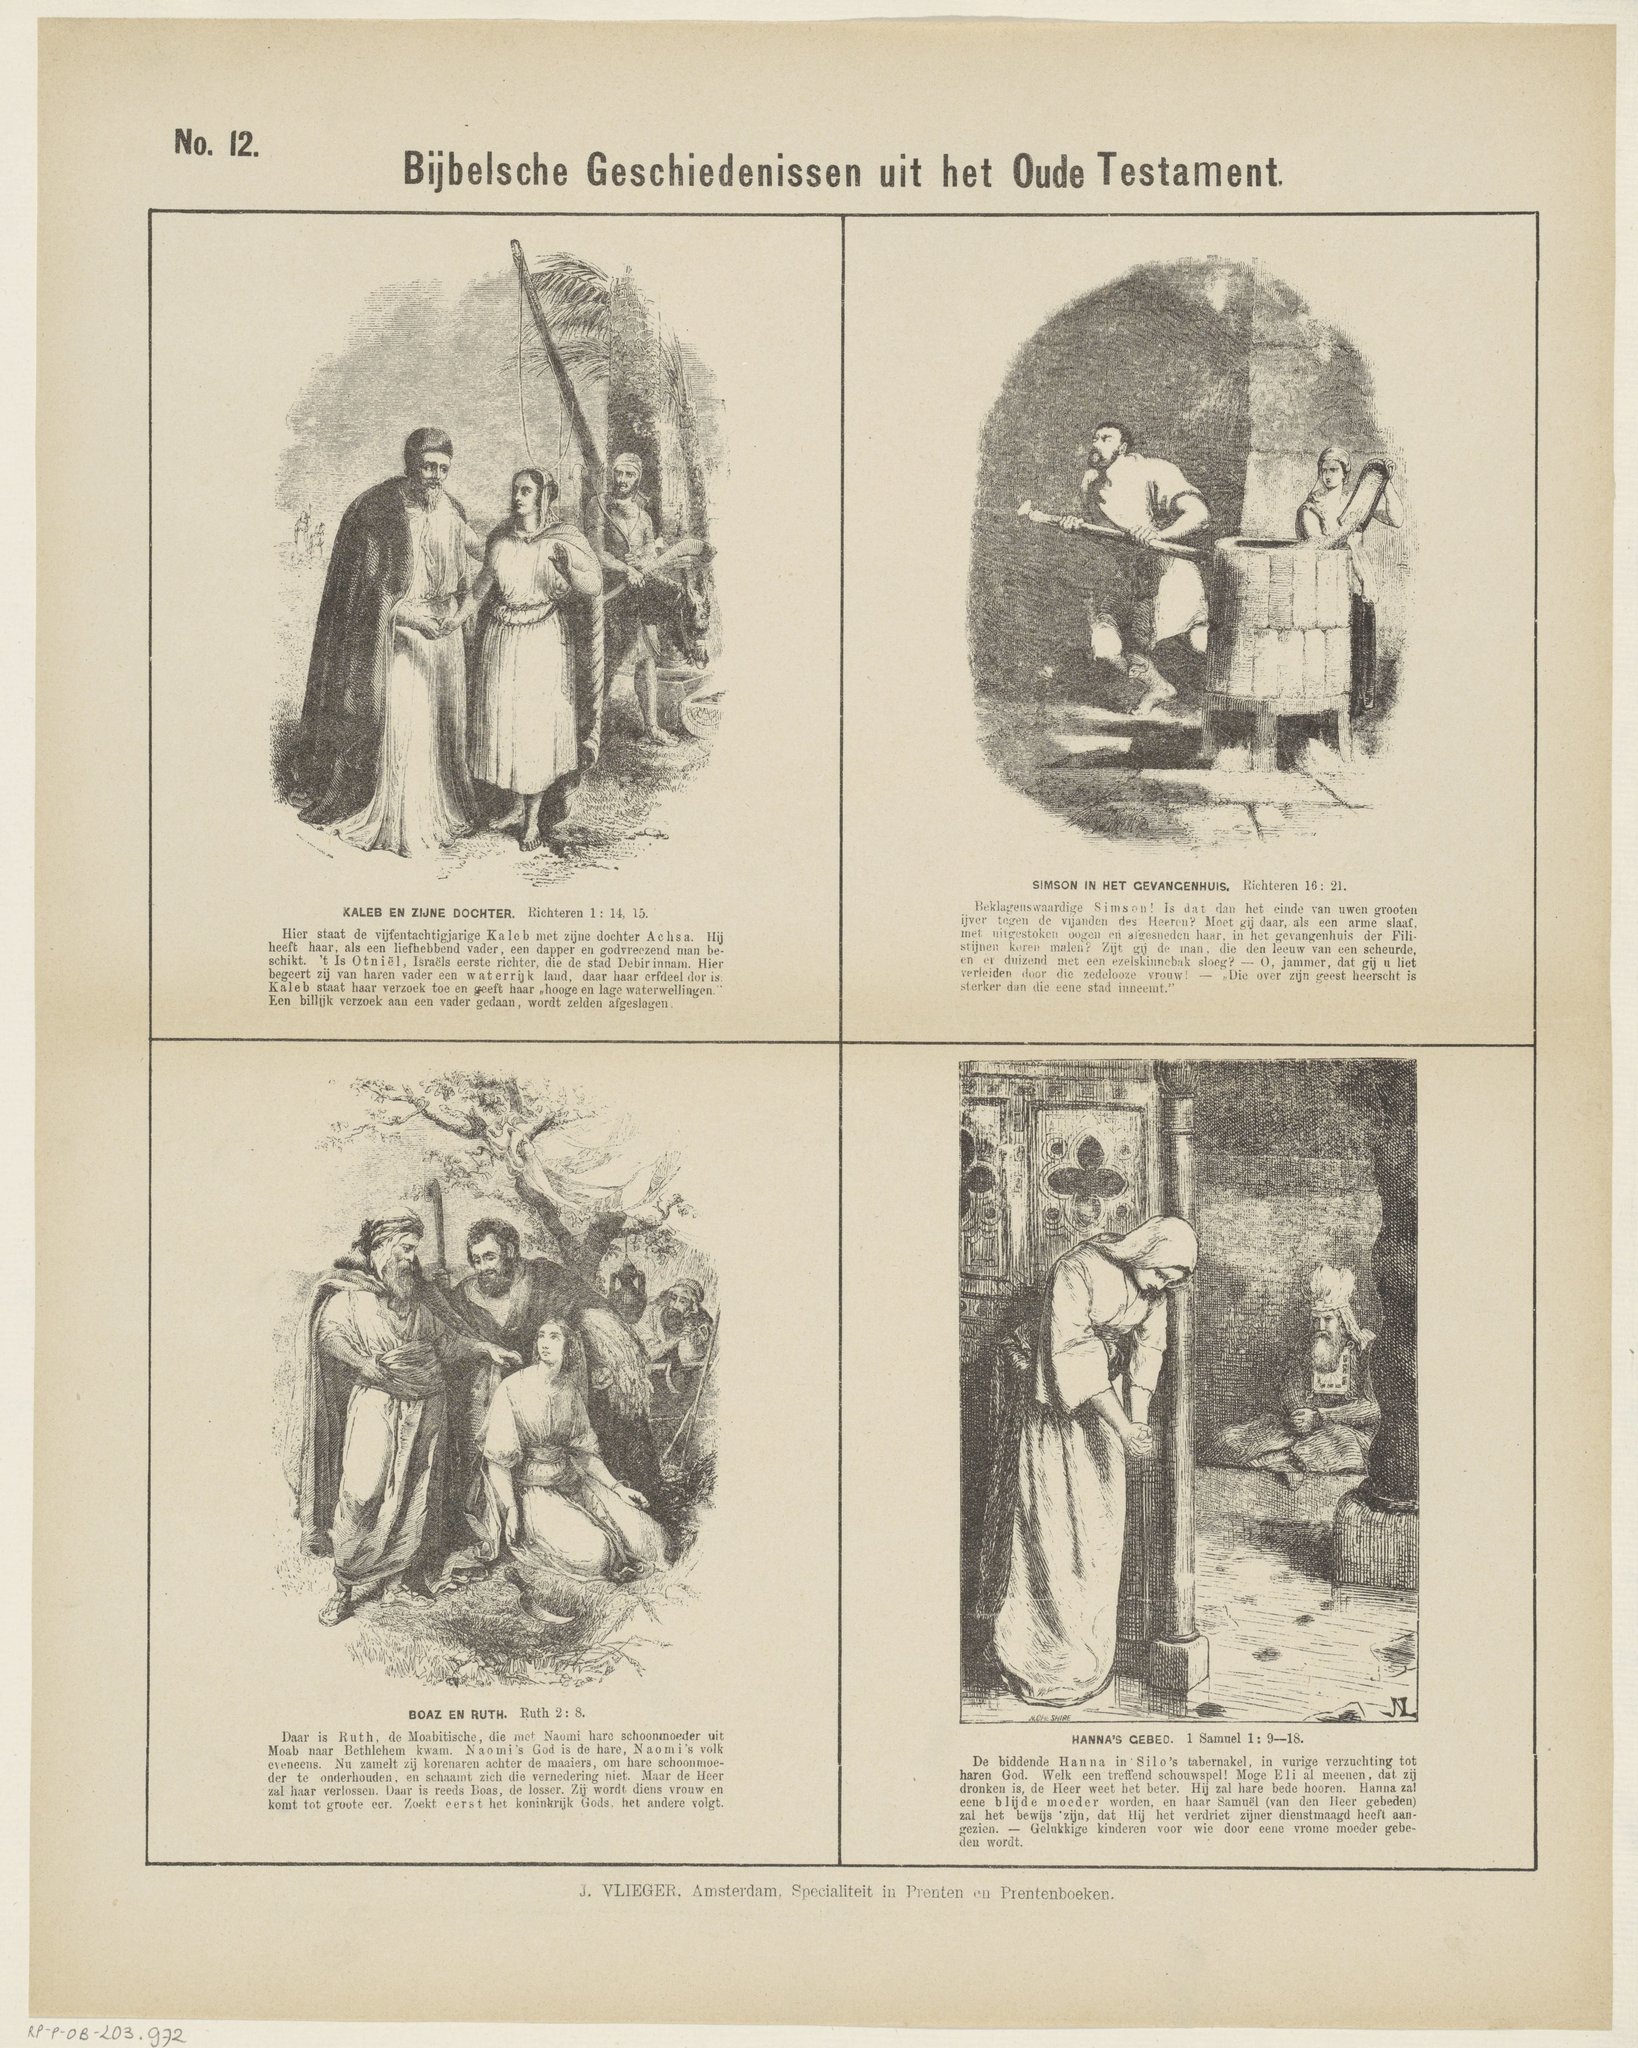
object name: popular print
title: Bijbelsche geschiedenissen uit het Oude Testament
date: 1871-1908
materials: paper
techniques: letterpress printing, engraving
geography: amsterdam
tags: samson grinding in prison (in a treadmill), ruth and naomi in bethlehem (ruth 2:1-2), hannah's prayer and song of thankfulness, old testament, othniel conquers debir, and receives caleb's daughter achsah to wife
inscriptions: collector's mark: Lugt 2760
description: Blad met 4 voorstellingen van verhalen uit het Oude Testament. Kaleb en zijn dochter, Simson in de gevangenis, Boaz en Ruth en Hanna's gebed. Onder elke afbeelding de bijbehorende Bijbeltekst. Genummerd linksboven: No. 12.